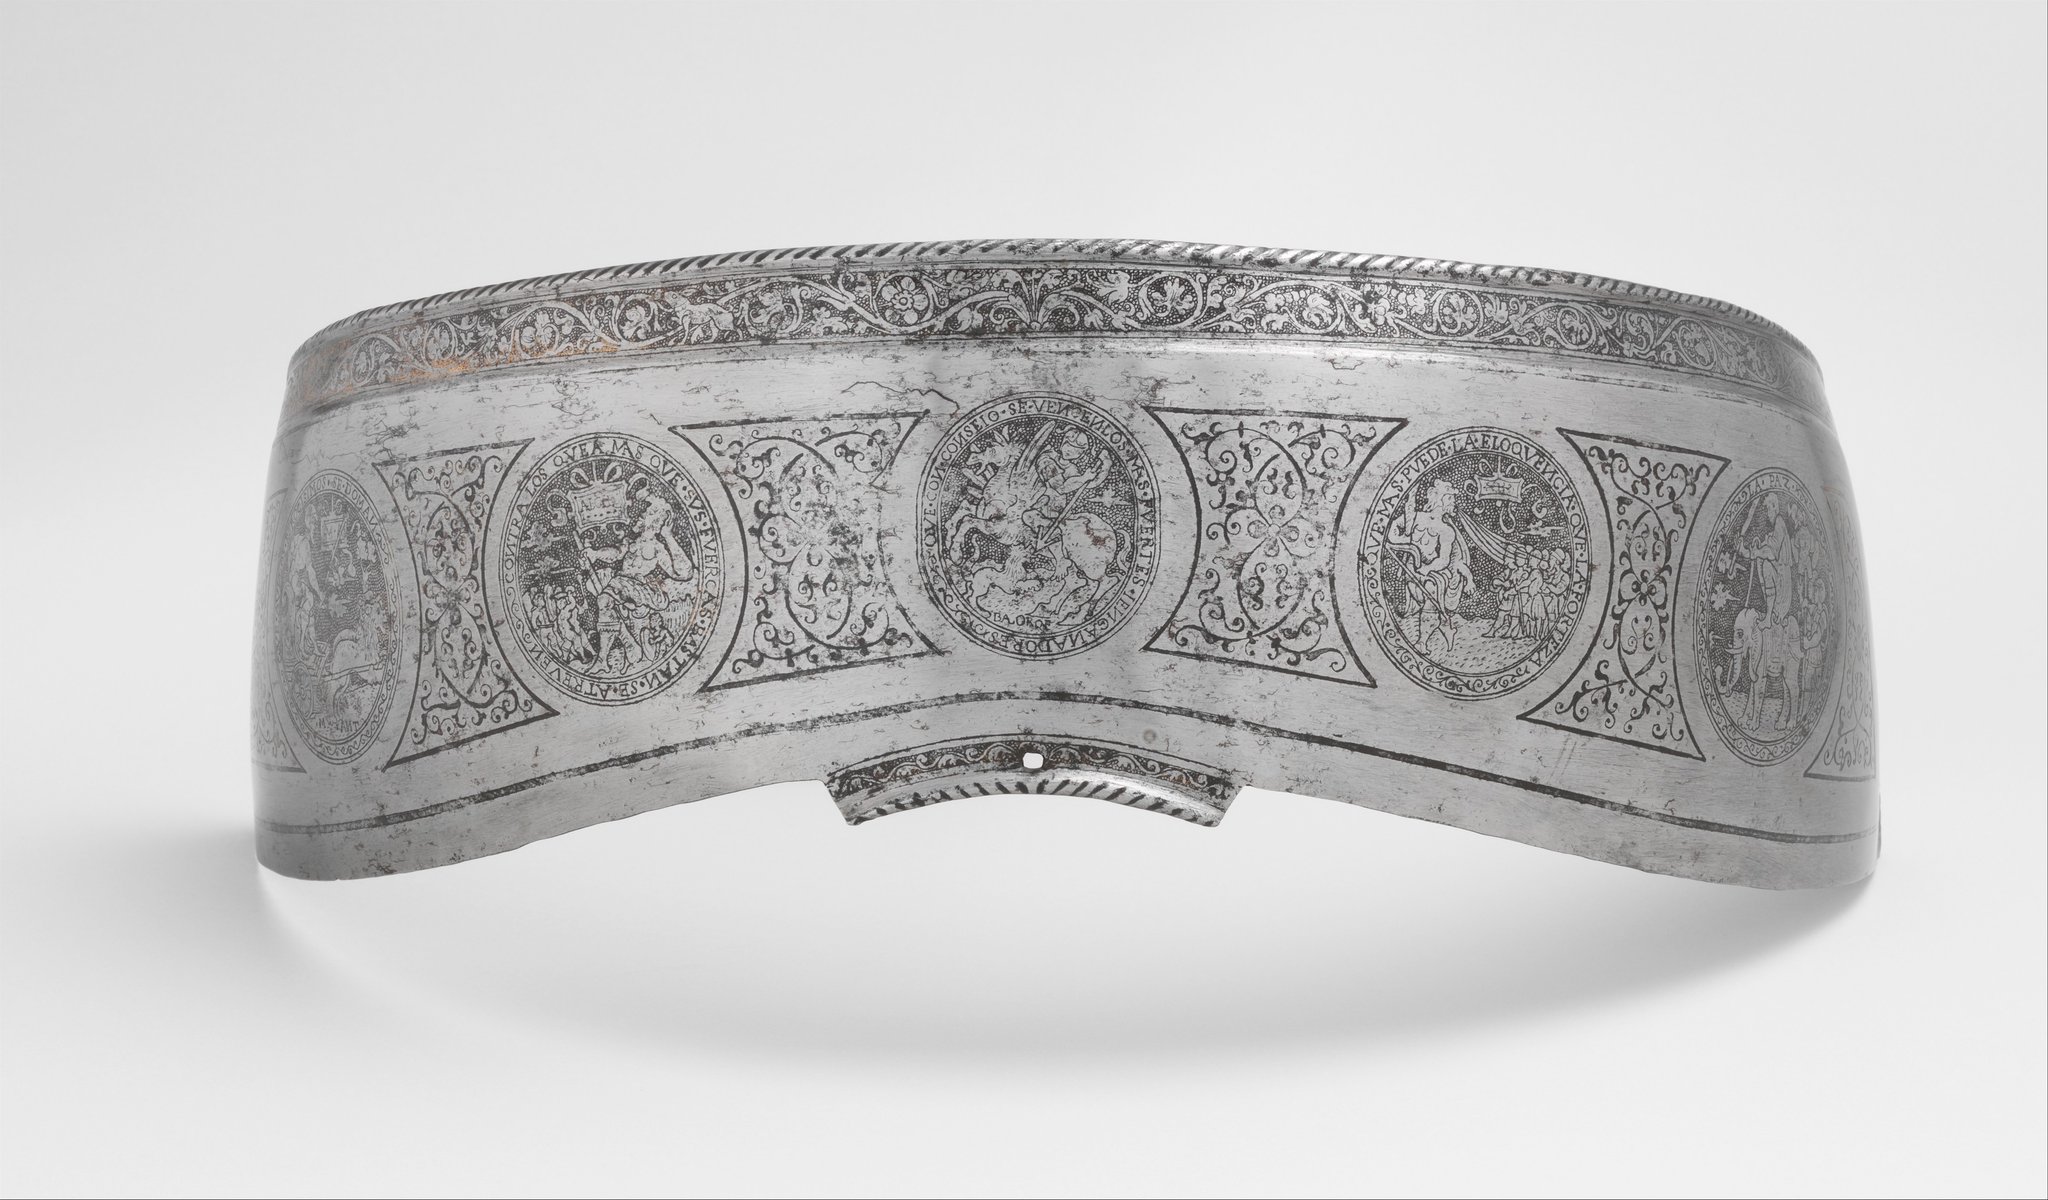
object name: cantle plate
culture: italian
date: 1550-1560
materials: gold, steel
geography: italy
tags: men,elephants,horses